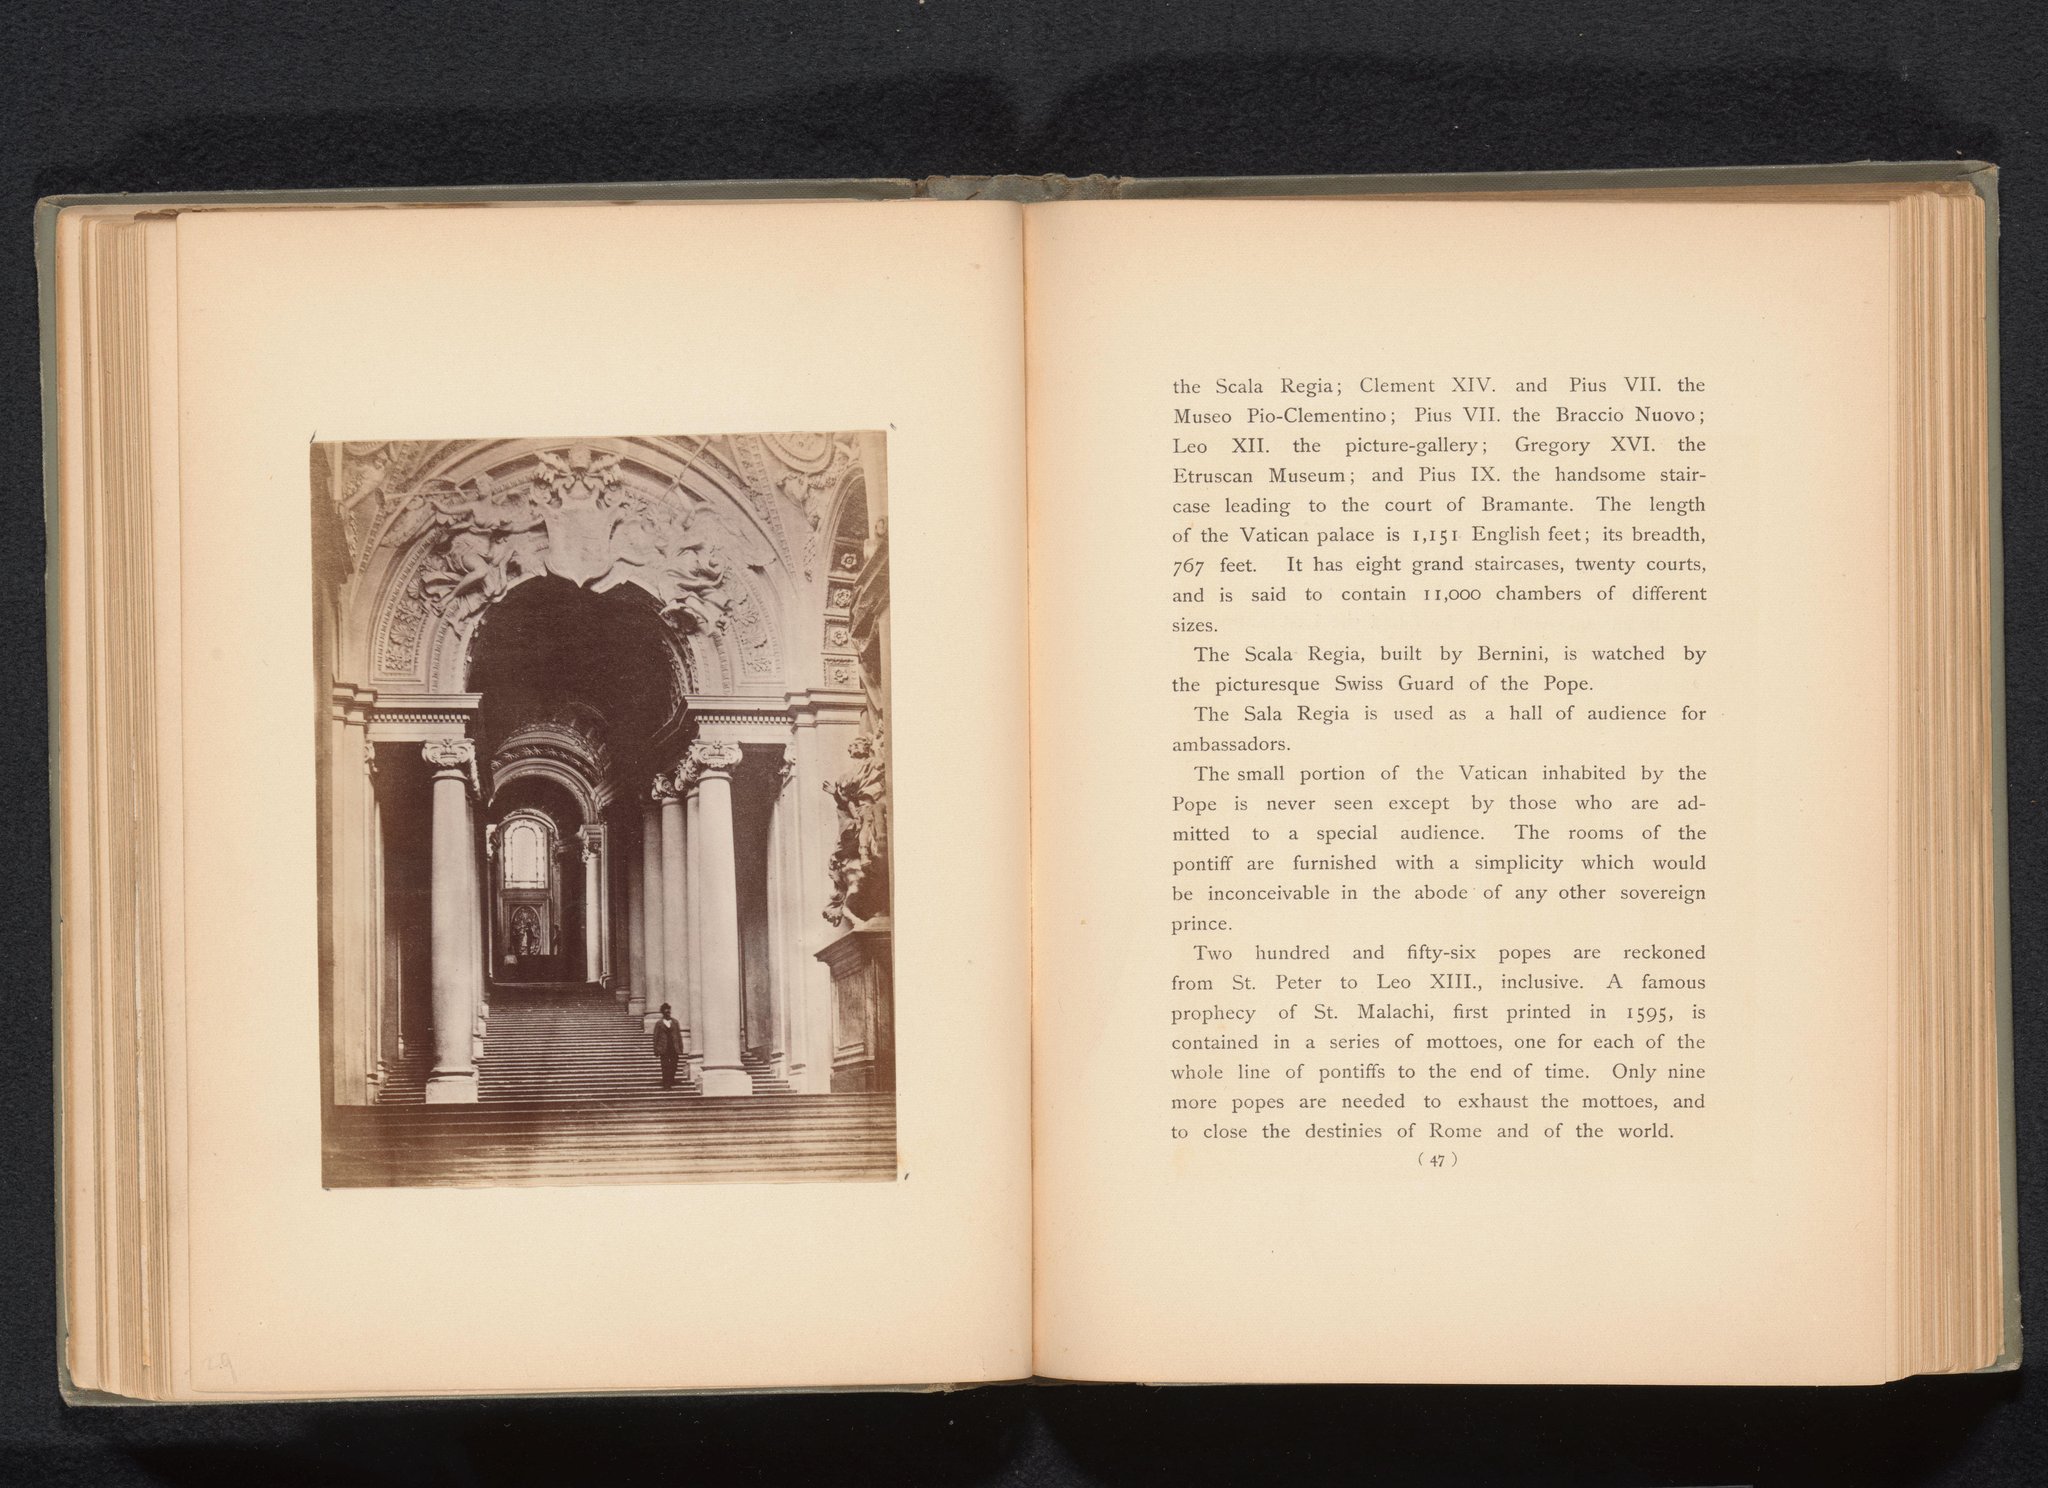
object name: page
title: Scala Regia in het Apostolisch Paleis te Vaticaanstad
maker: Anonymous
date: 1882-1887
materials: photographic support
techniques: albumen print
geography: apostolisch paleis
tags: staircase